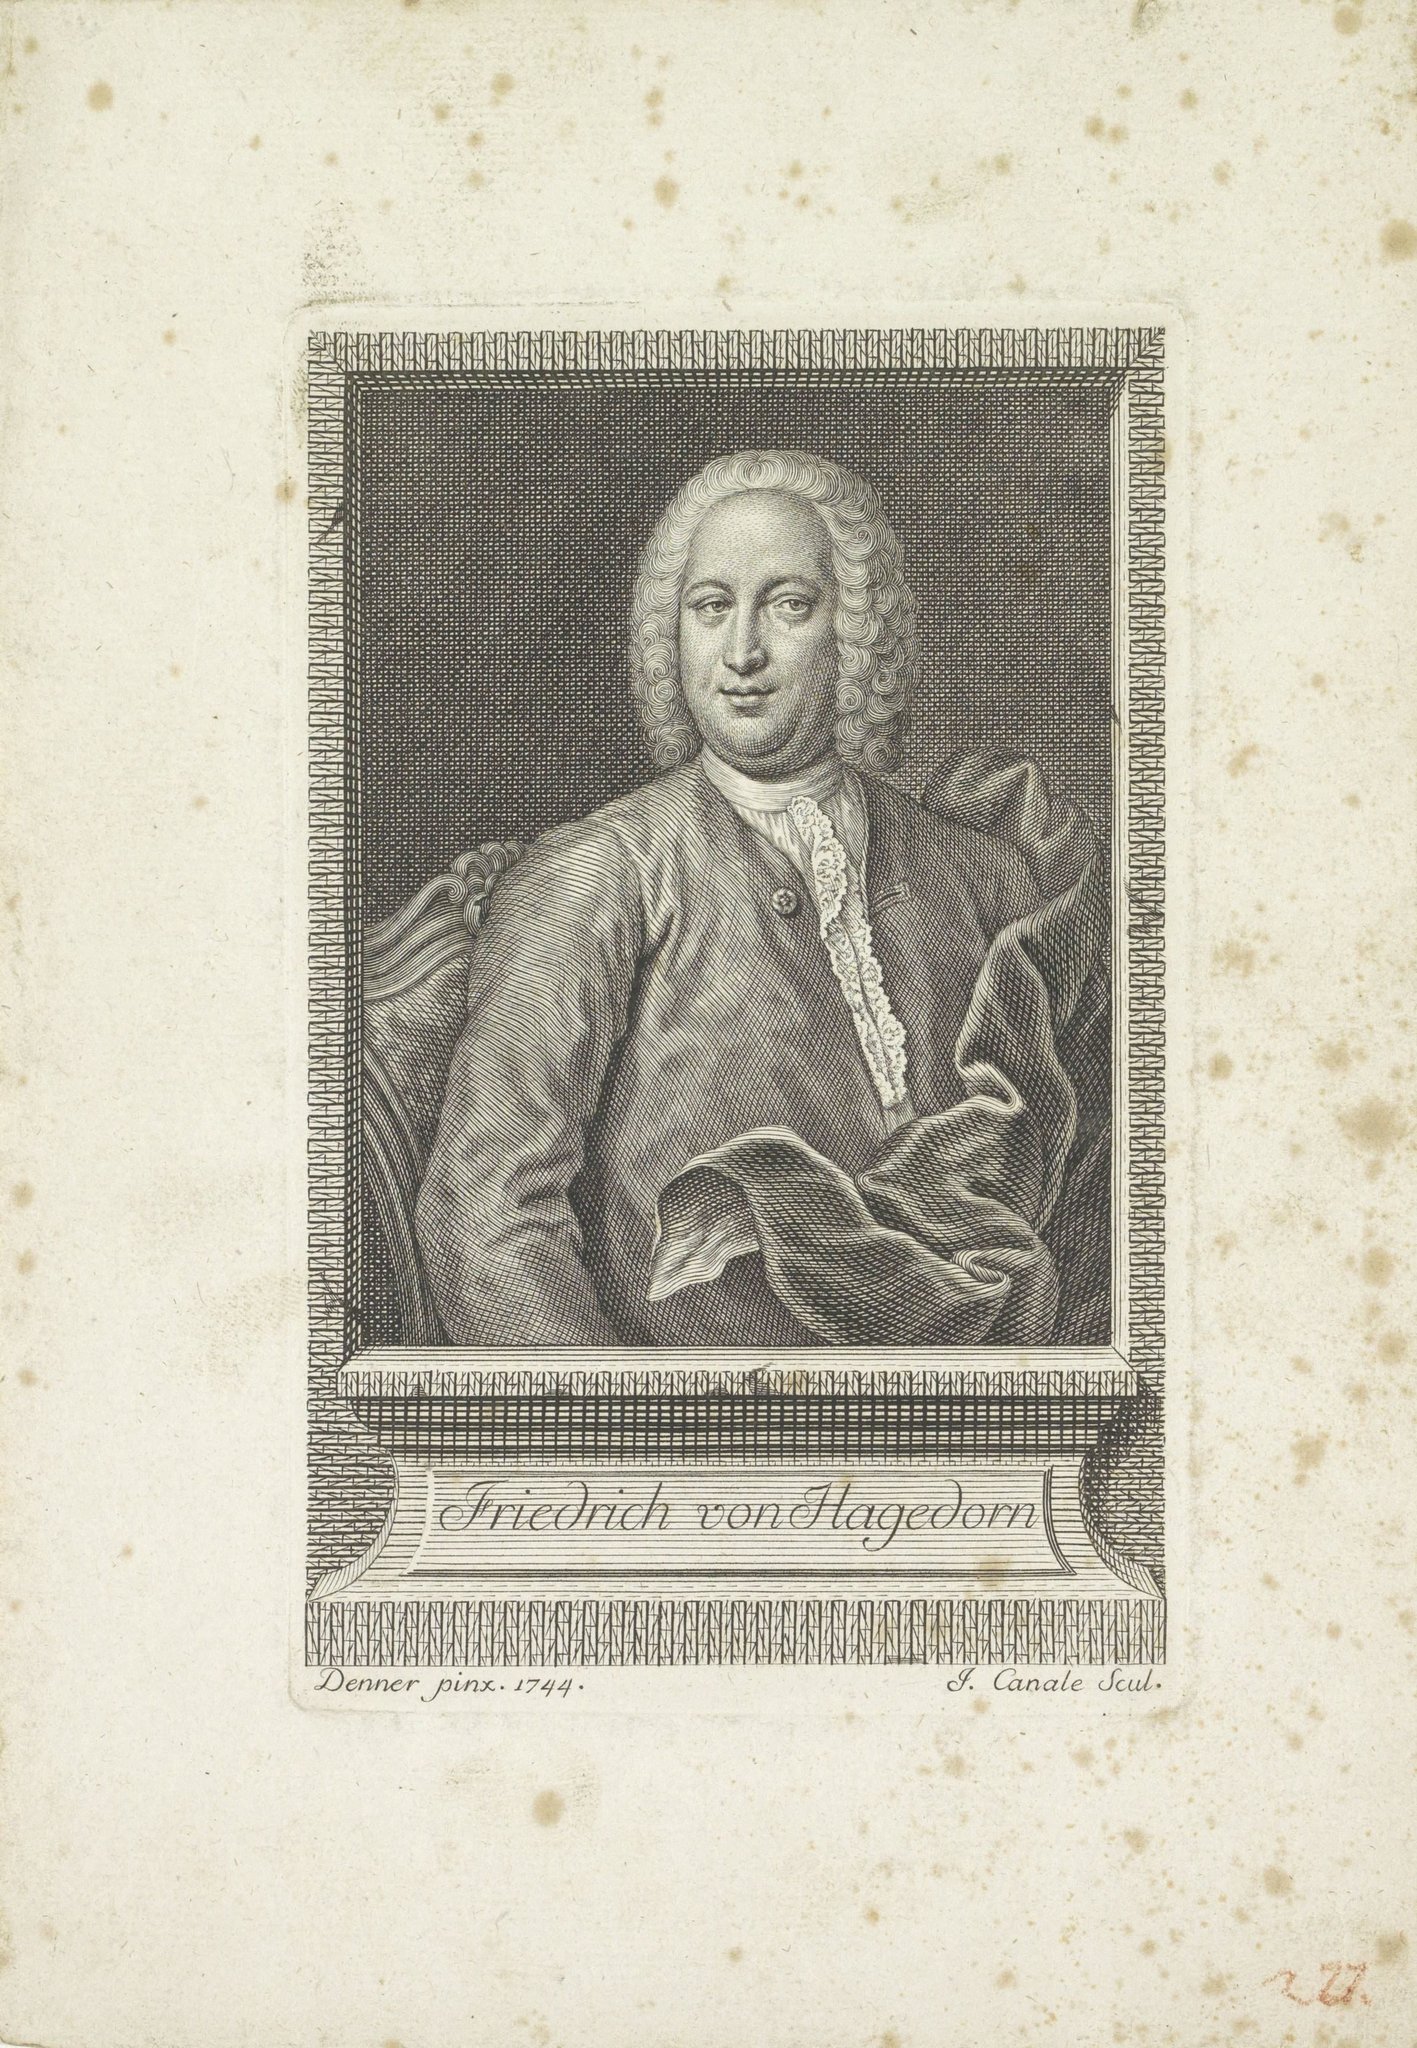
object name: print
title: Portret van de dichter Friedrich von Hagedorn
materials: paper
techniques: engraving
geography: italy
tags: historical persons, portrait of a writer, writer, poet, author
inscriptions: collector's mark: Lugt 2233